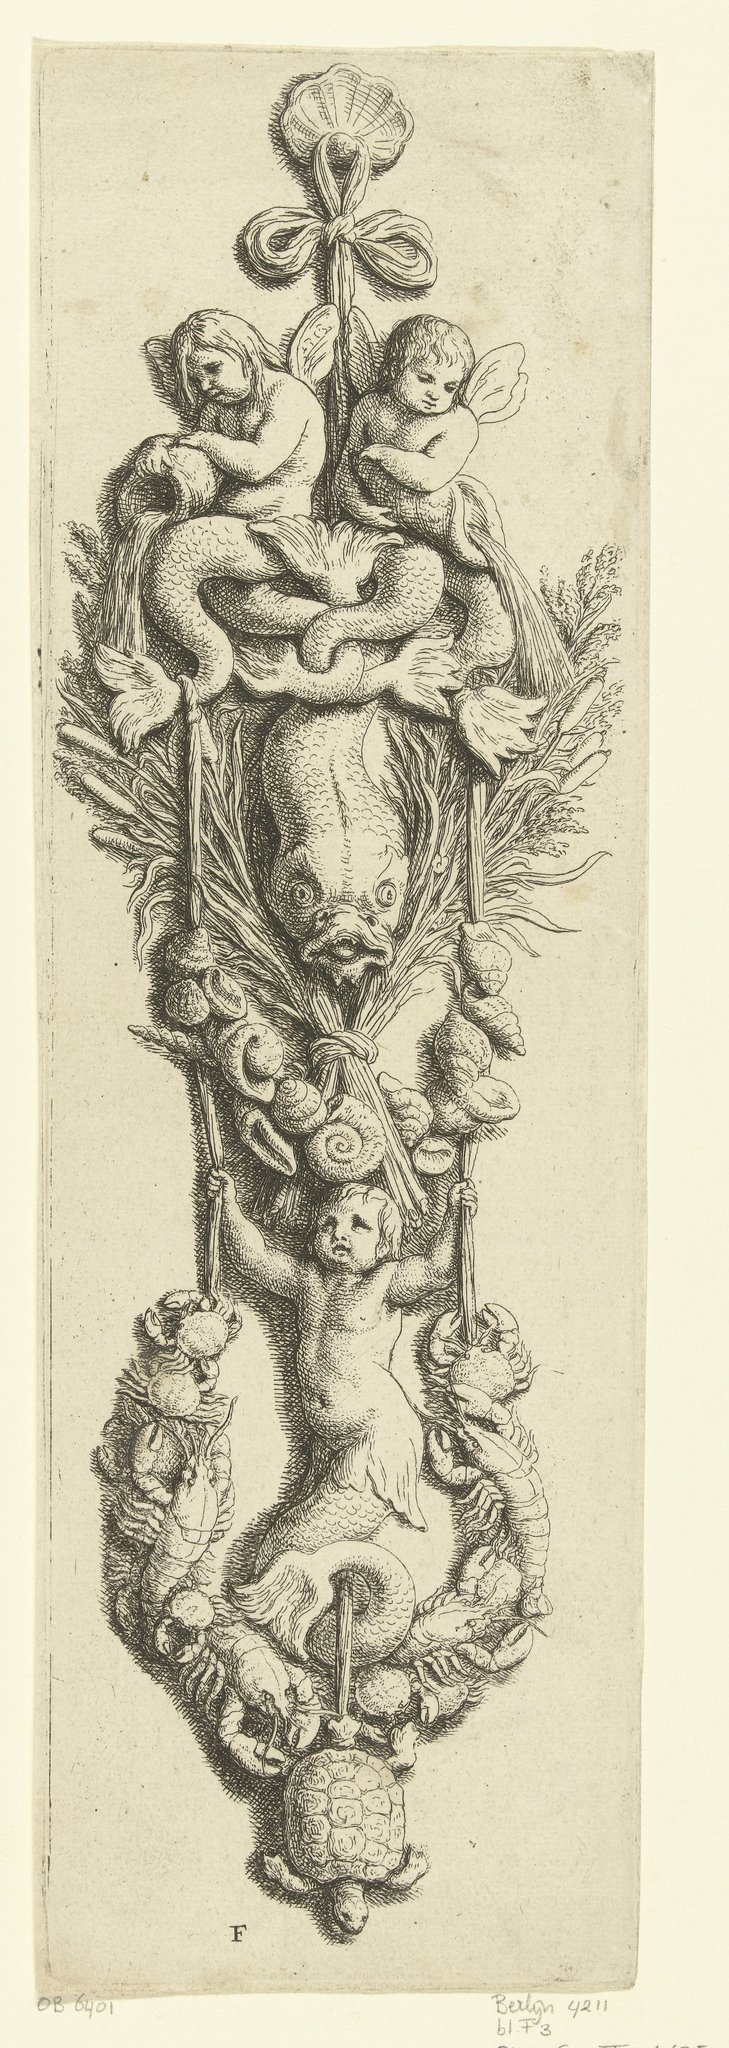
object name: ornament print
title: Secunda Pars Praecipuarum (...)/Het Tweede Deel Van de voornaemste Statuen ende Cieraten (...)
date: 1663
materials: paper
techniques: etching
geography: amsterdam